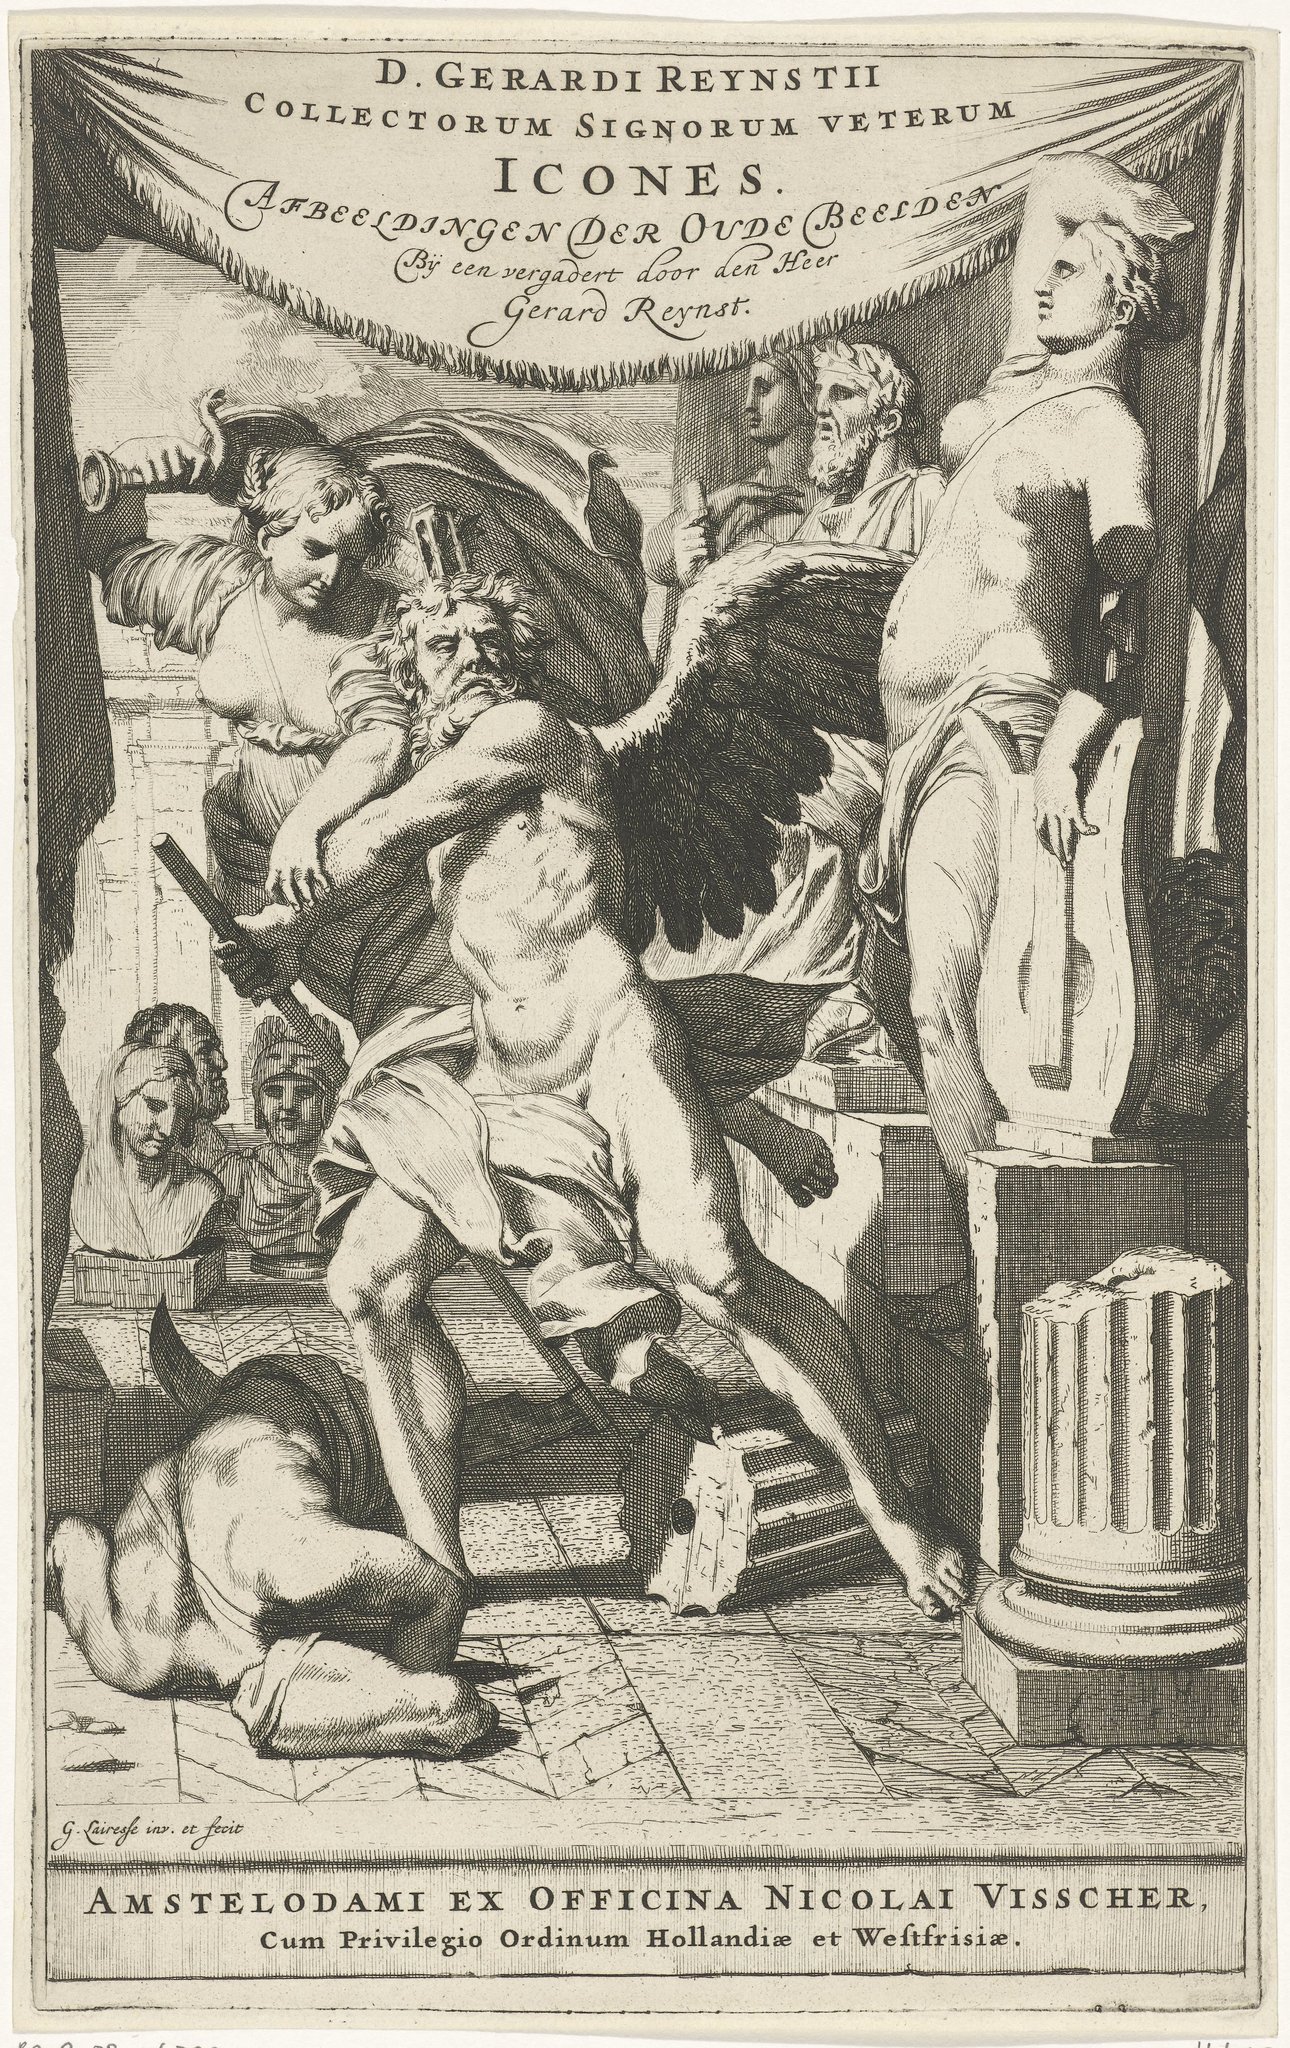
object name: titelblad, titelpagina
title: Voorzichtigheid weerhoudt de Tijd ervan antieke beelden te vernietigen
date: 1670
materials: paper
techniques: etching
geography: amsterdam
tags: prudence, 'prudentia'; 'prudenza' (ripa) ~ one of the four cardinal virtues, allegorical representations of the effects of time, sculpture, father time, man with wings and scythe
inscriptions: collector's mark: Lugt 240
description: De Tijd (Chronos, gevleugelde zandloper) wil met een stok uithalen om een antiek beeld stuk te slaan. Hij wordt hierin tegengehouden door de Voorzichtigheid (Prudentia, slang met spiegel) die zijn arm heeft vastgepakt. Links ligt een reeds vernield beeld op de grond.